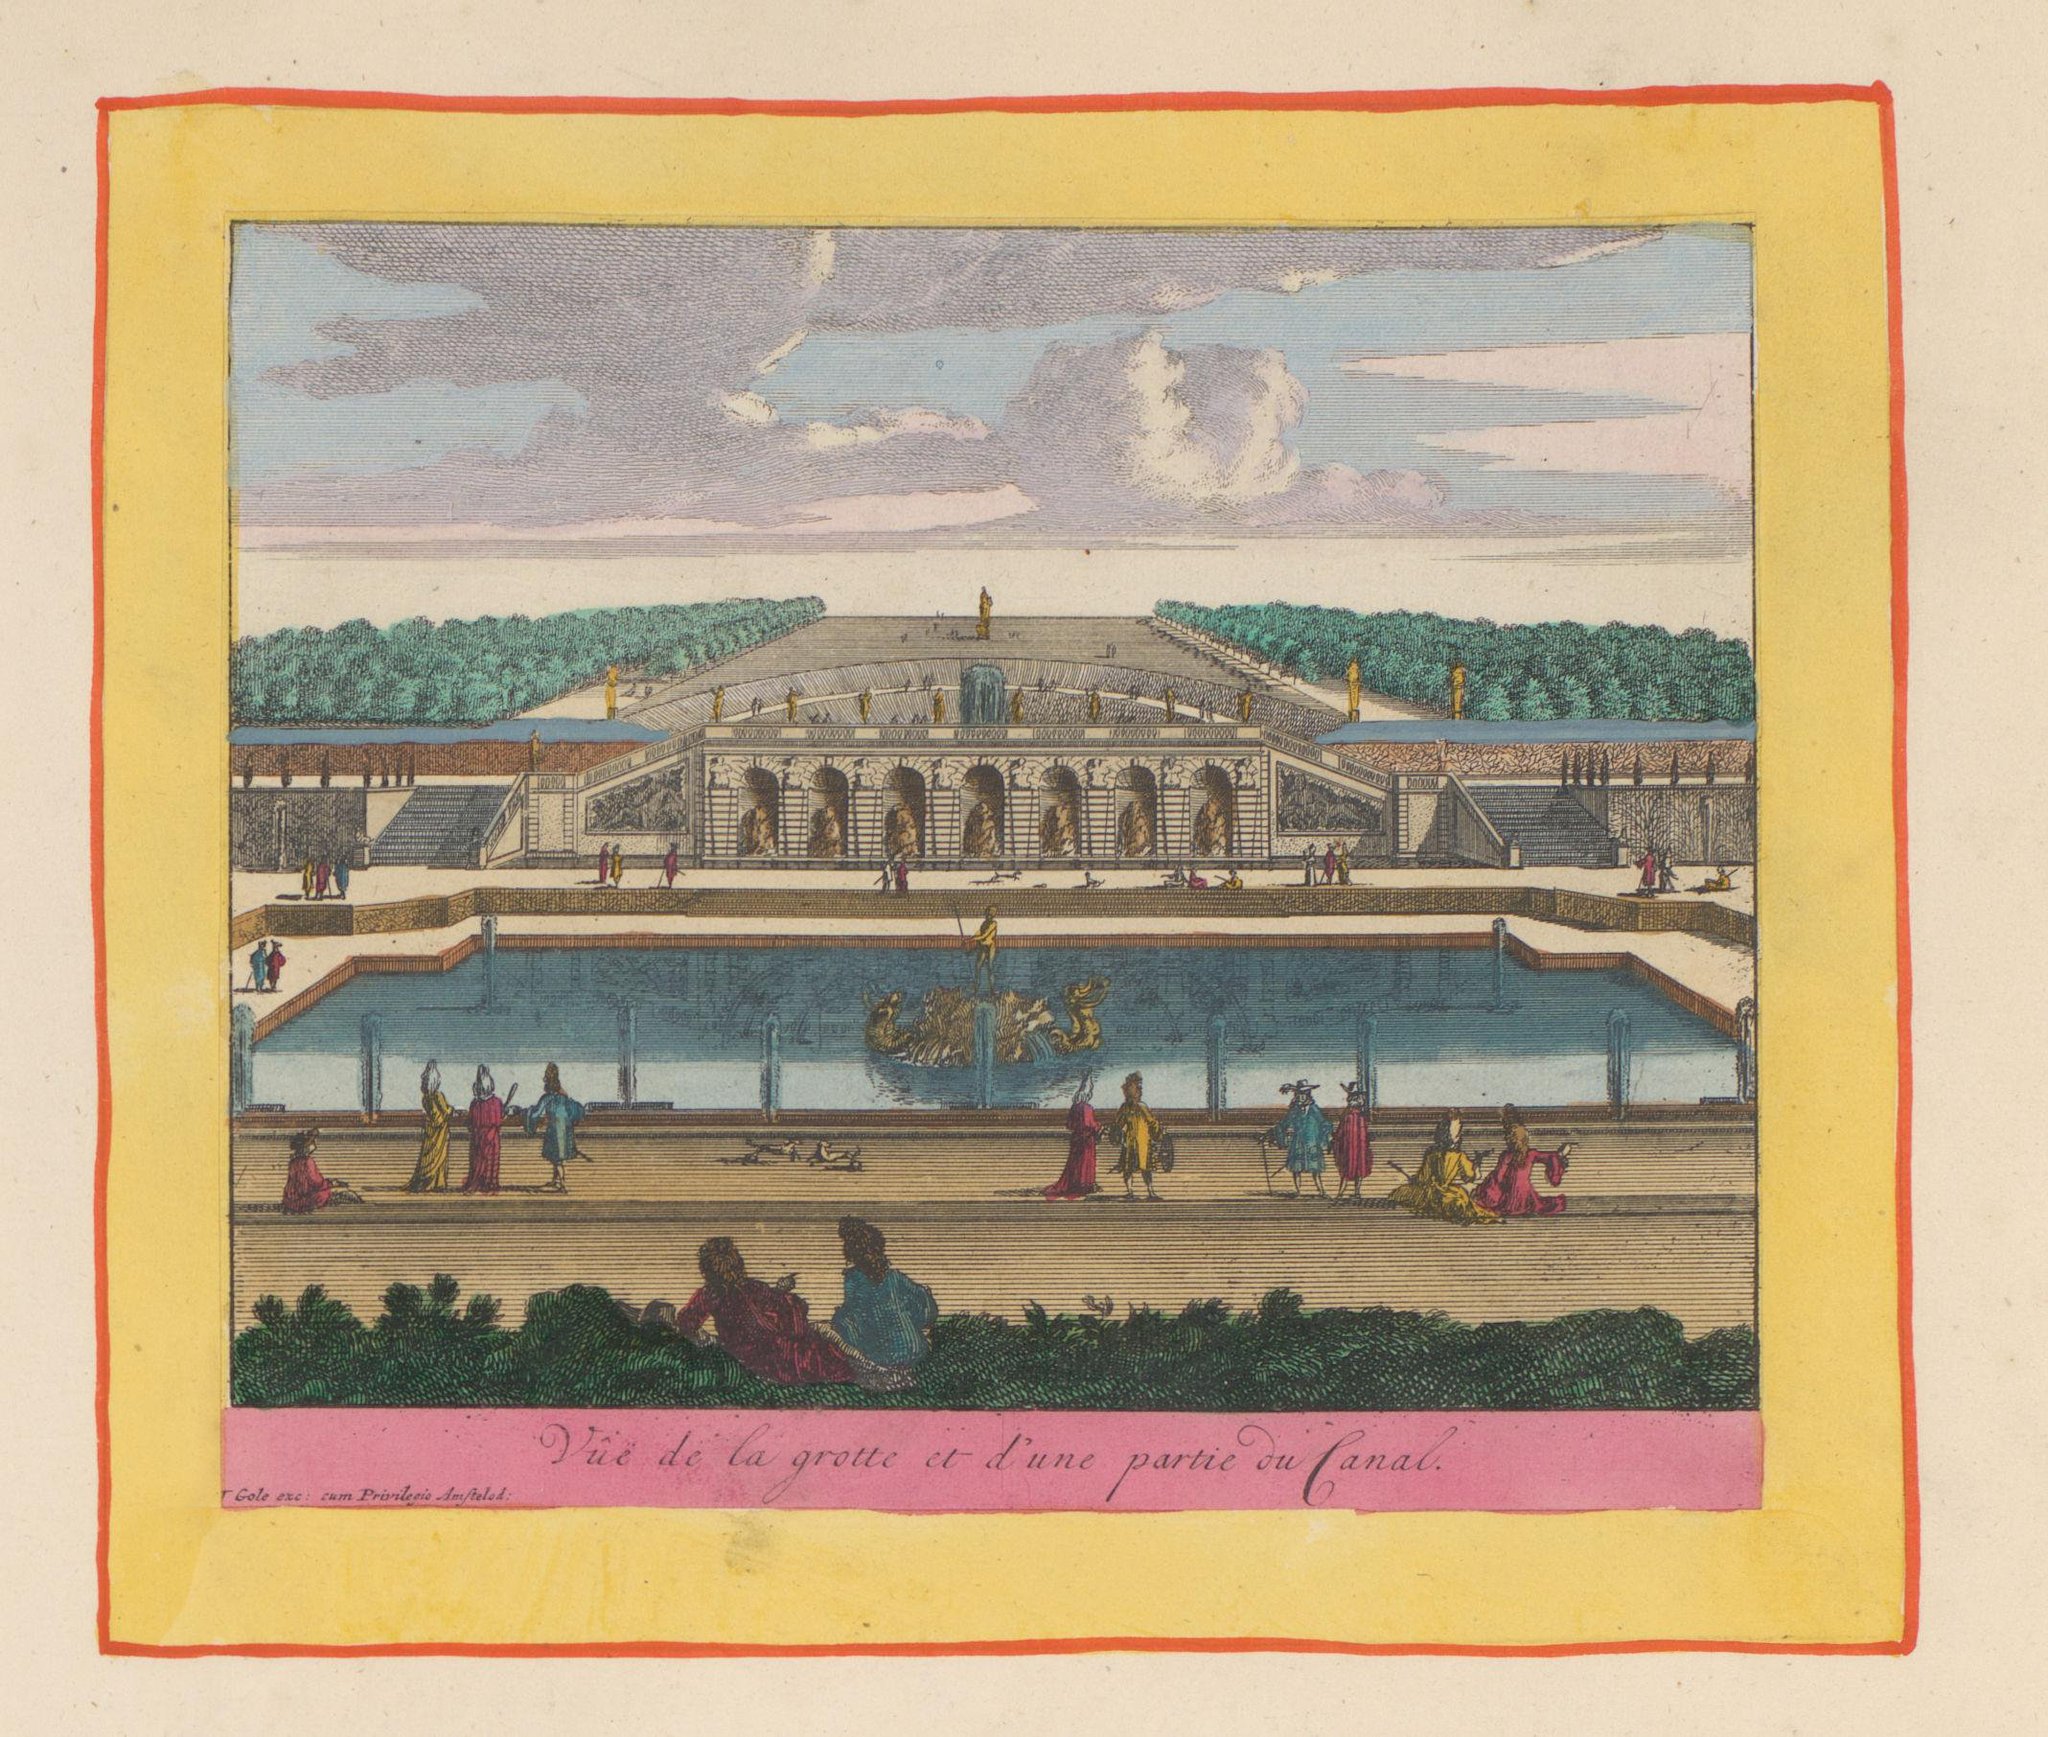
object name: album leaf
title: Vûe de la grotte et d'une partie du Canal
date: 1681-1724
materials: paper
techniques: etching, hand coloring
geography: the hague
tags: french or architectonic garden; formal garden, artificial grotto in garden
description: Gezicht op de grot in de tuinen van Château de Vaux-le-Vicomte. Op de voorgrond een deel van het kanaal. Prent maakt deel uit van een album.